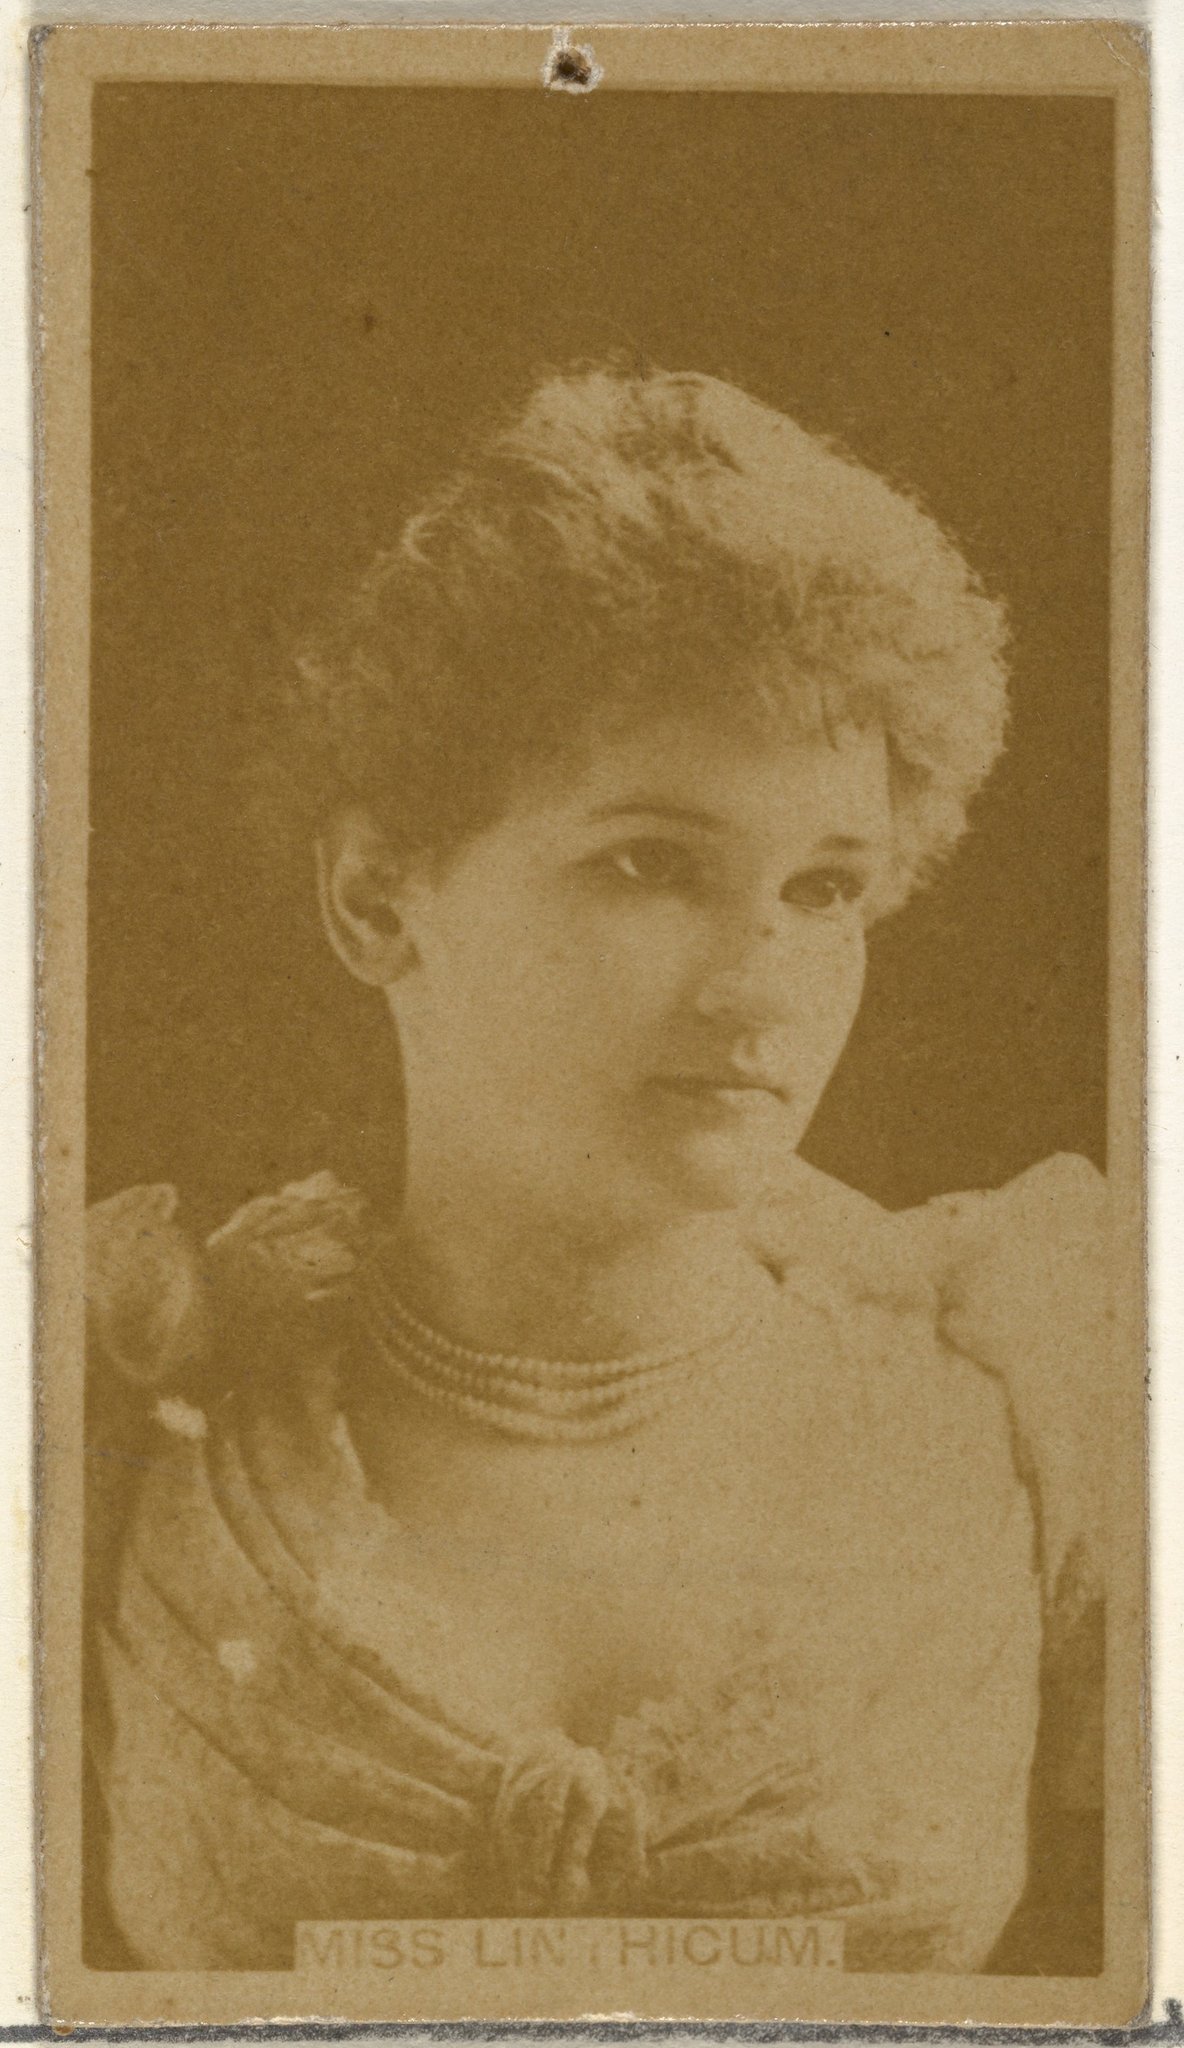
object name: photograph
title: Miss Linthicum, from the Actors and Actresses series (N145-8) issued by Duke Sons & Co. to promote Duke Cigarettes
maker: w. duke, sons & co.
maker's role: publisher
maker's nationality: american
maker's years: 1870-1920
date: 1891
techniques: albumen silver print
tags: portraits,women,actresses